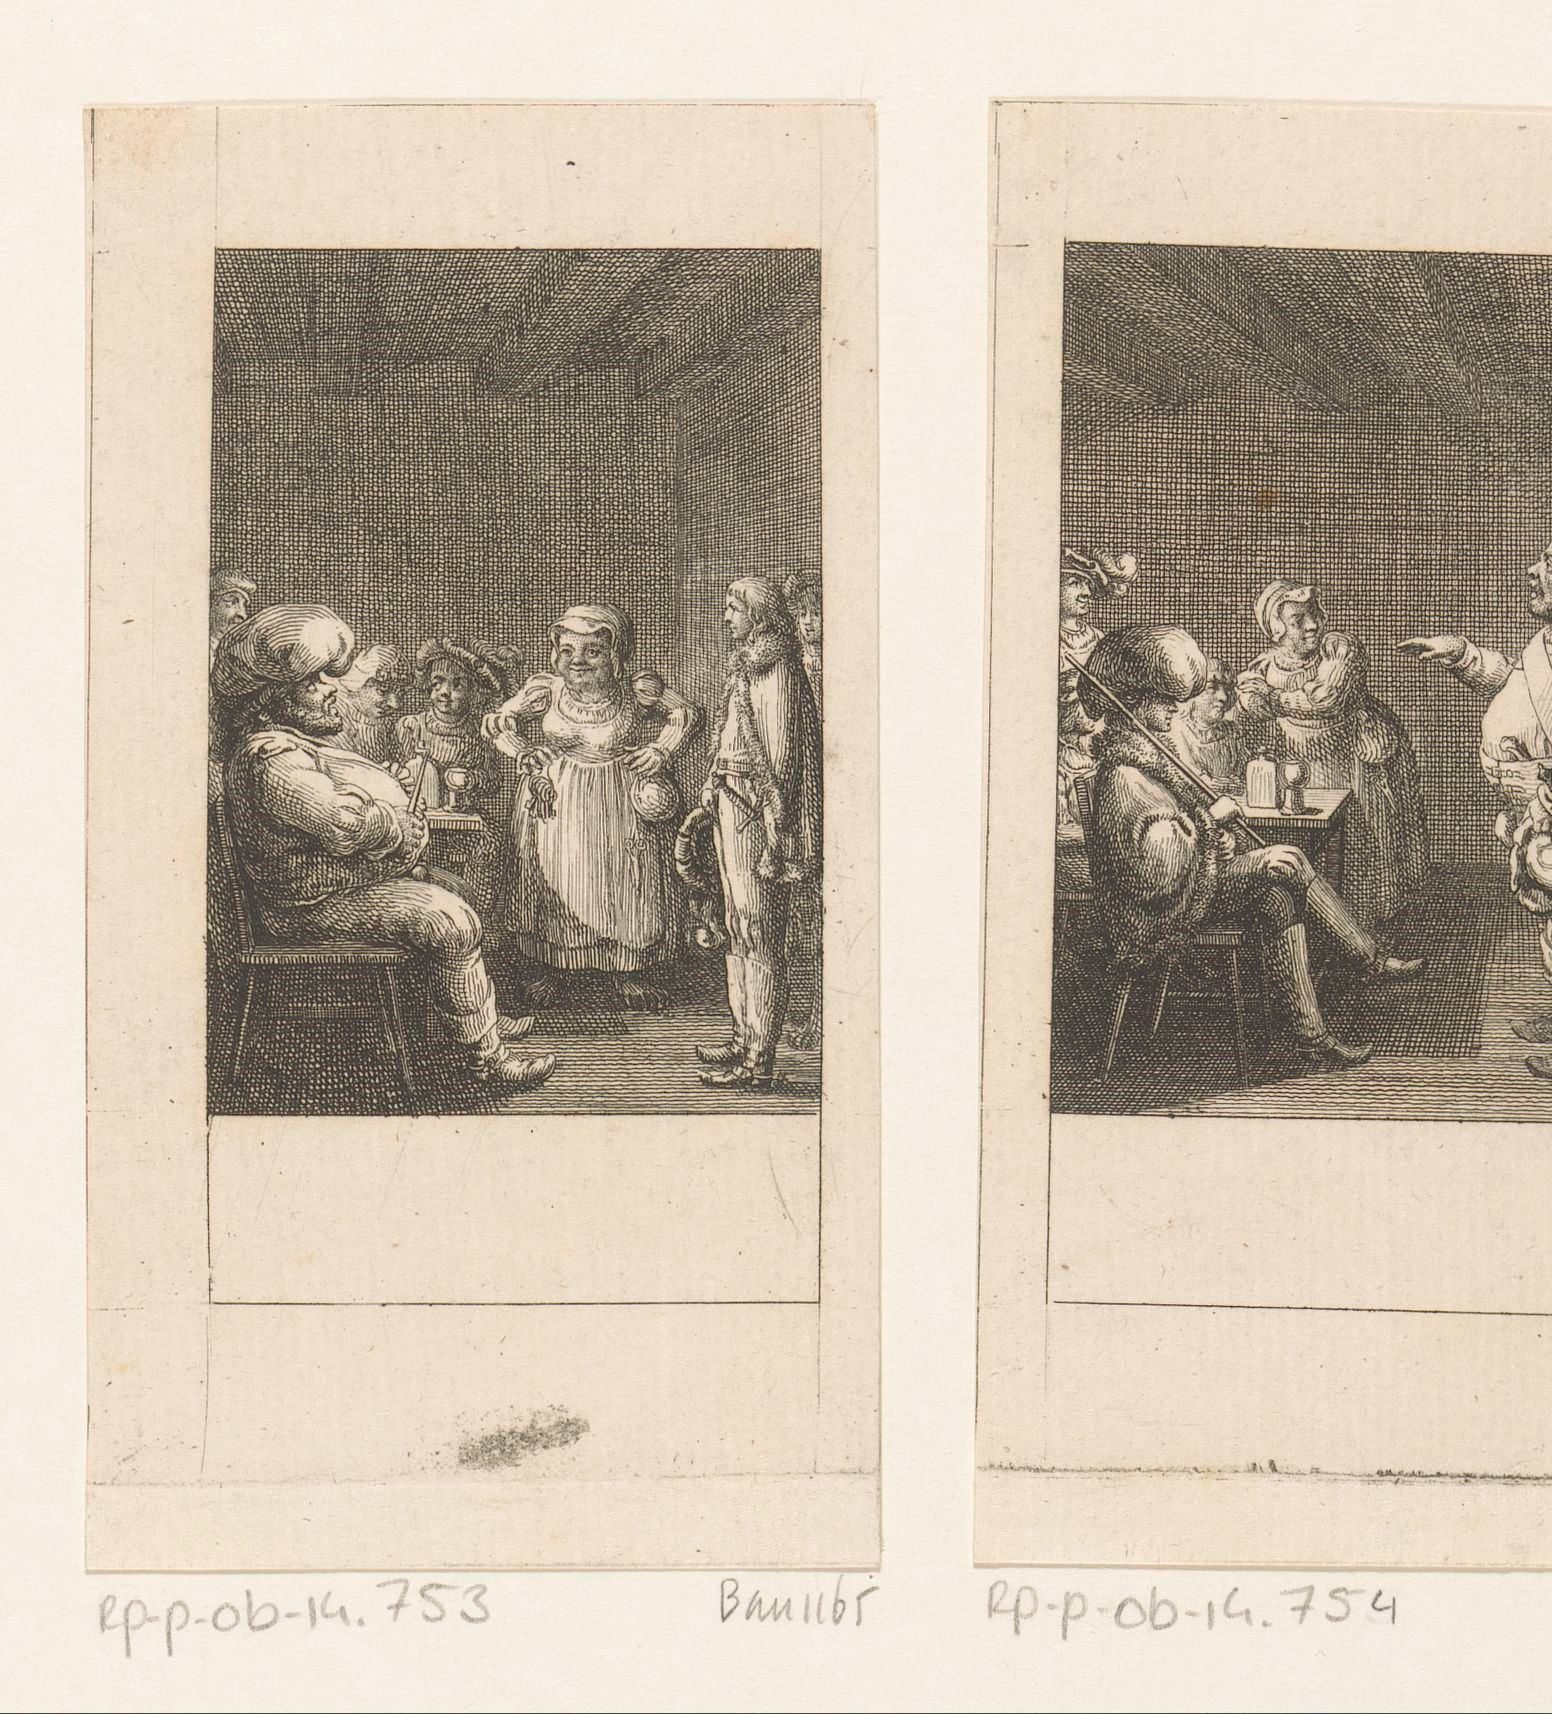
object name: print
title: Falstaff verkleed als vorst voor Henry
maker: daniel nikolaus chodowiecki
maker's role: draughtsman, print maker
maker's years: 1726-1801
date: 1785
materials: paper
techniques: etching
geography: berlin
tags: william shakespeare, fat (human type), literature, ruler, sovereign, clothes, costume, falstaff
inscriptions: collector's mark: Lugt 2228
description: Vervaardigd voor William Shakespeares 'Henry IV'. Latere staat gebruikt voor: Goettinger Taschen Calender vom Jahr 1786. Göttingen: Johann Christoph Dietrich, 1785.